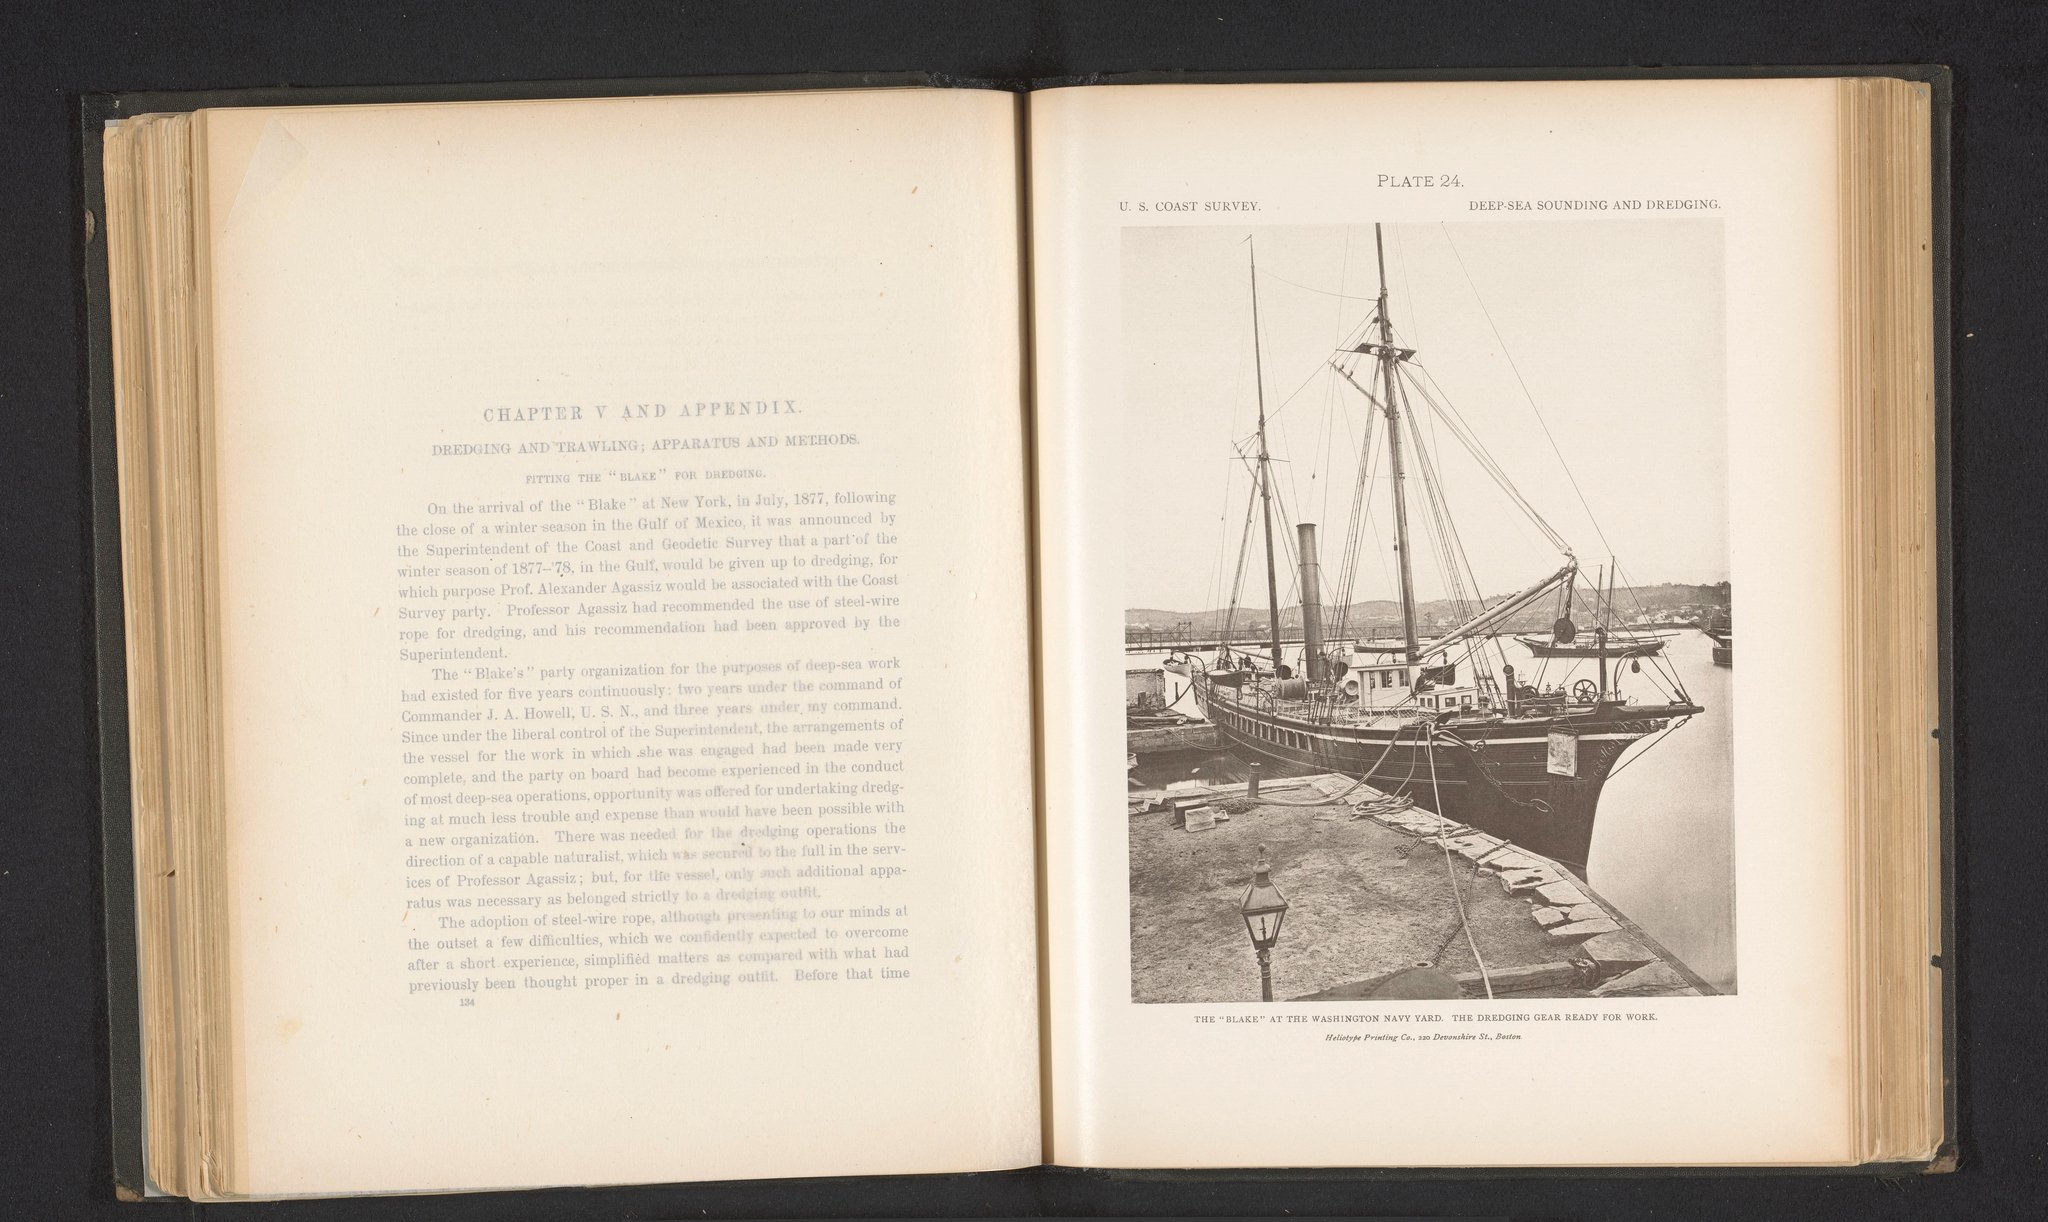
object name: photomechanical print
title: Gezicht op de George S. Blake in de marinewerf te Washington D.C.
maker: Anonymous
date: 1870-1880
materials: paper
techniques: photograph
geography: boston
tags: steamship, motorship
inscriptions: name: ‘Heliotype Printing Co., 220 Devonshire St., Boston.’, inscription: ‘The "Blake" at the Washington navy yard. The dredging gear ready for work.’, number: ‘Plate 24.’